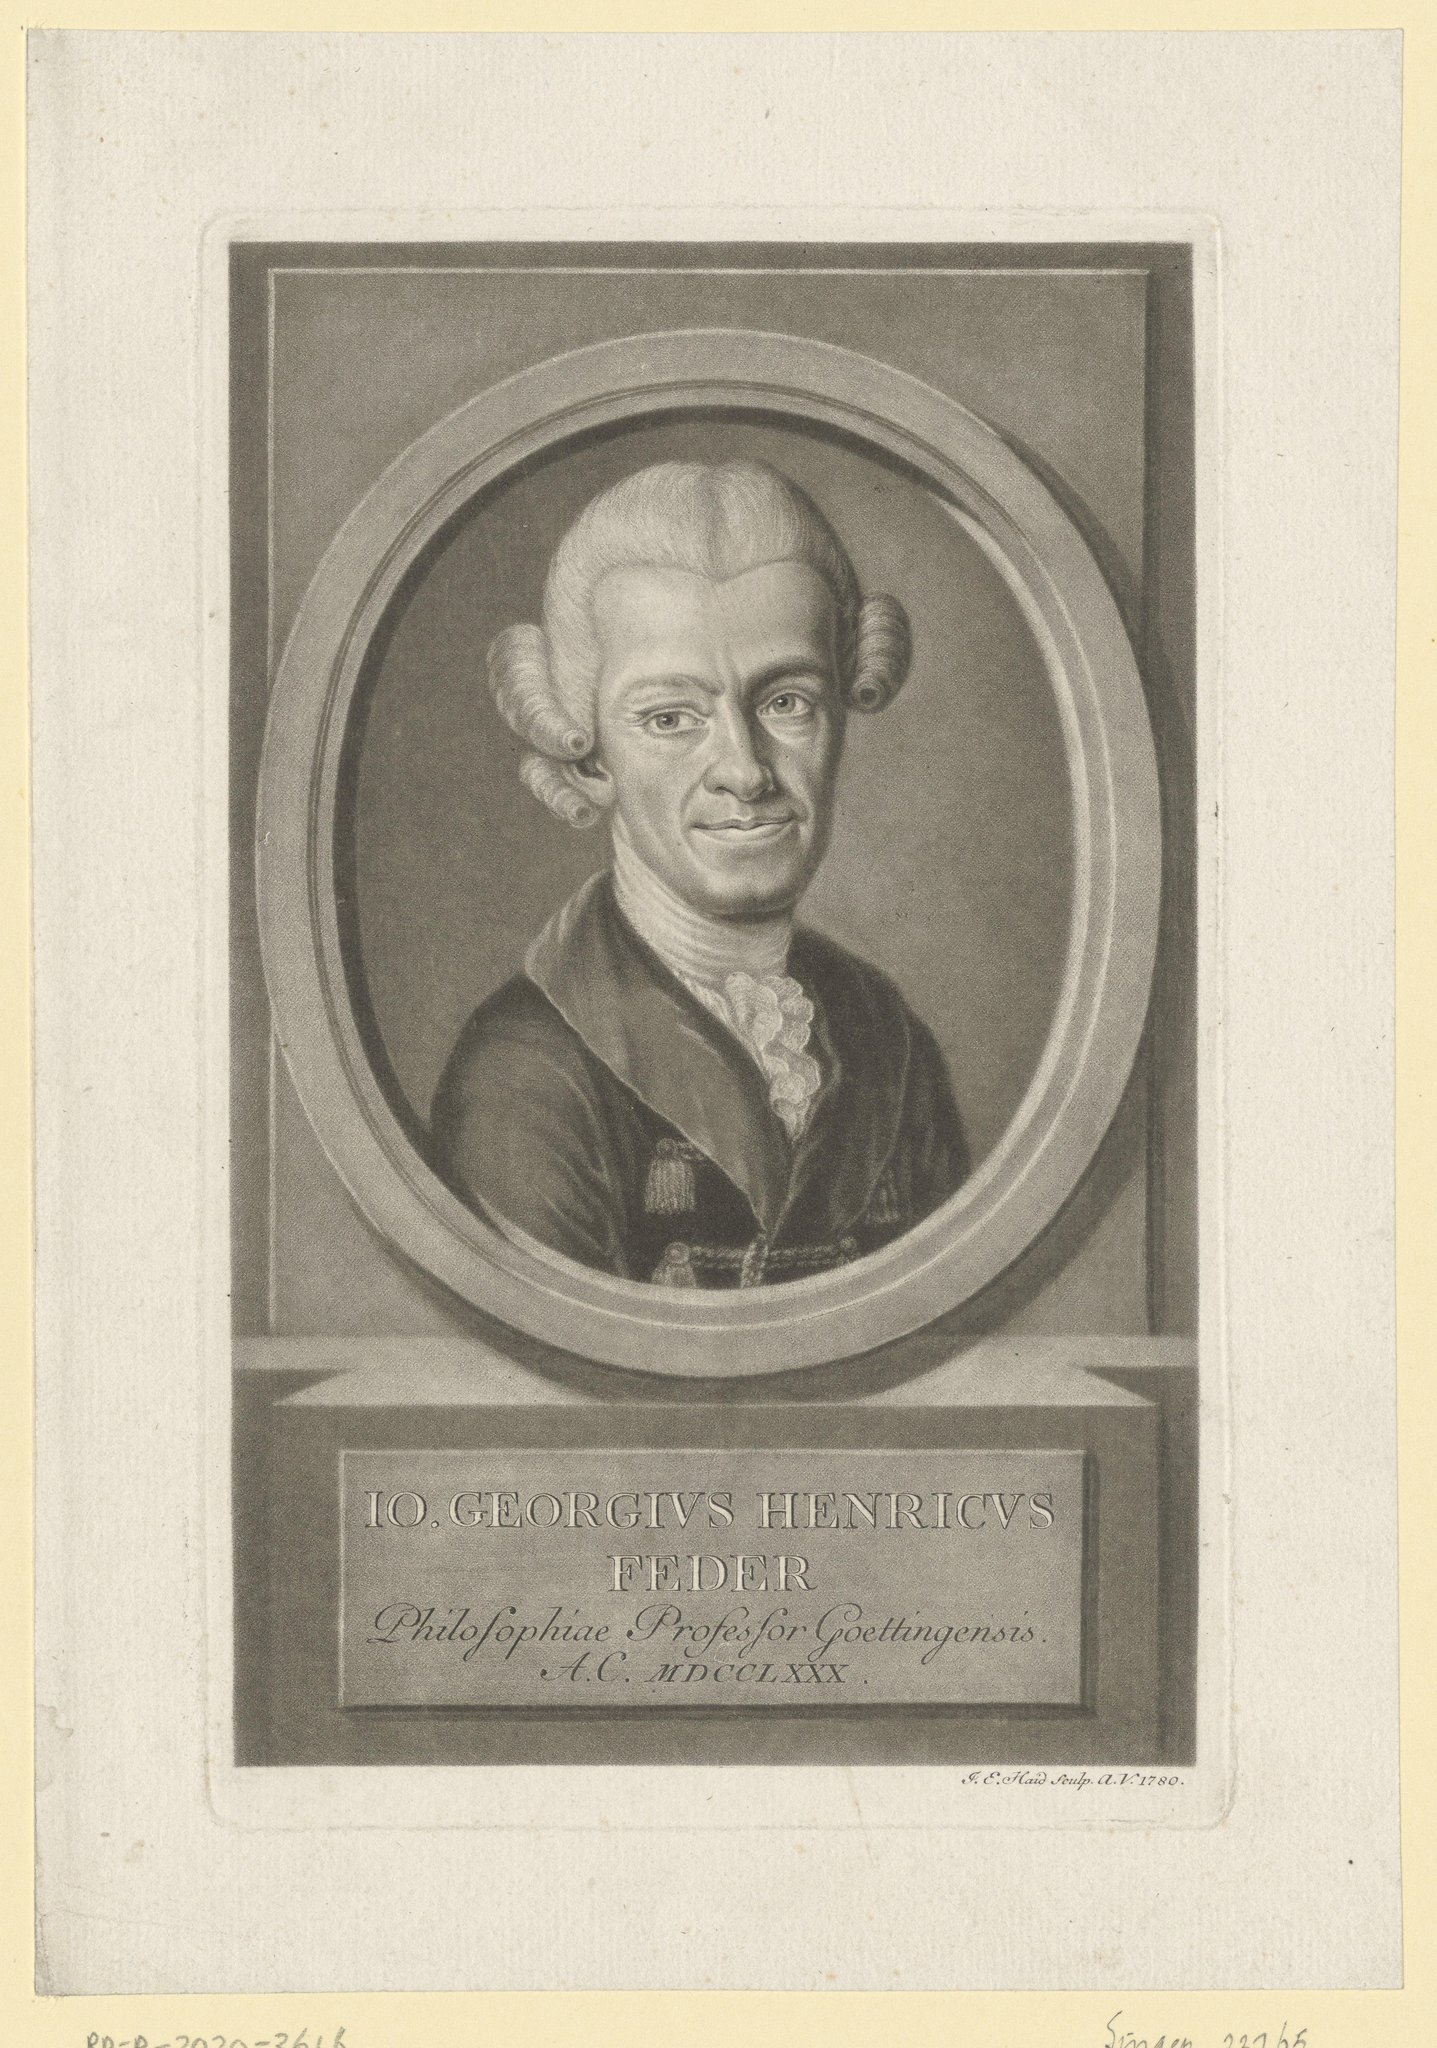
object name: print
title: Portret van Johann Georg Heinrich Feder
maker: johann elias haid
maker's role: print maker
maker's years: 1739-1809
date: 1780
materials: paper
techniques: mezzotint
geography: augsburg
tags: germany, historical persons, scholar, philosopher (+ portrait of scholar, scientist)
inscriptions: date